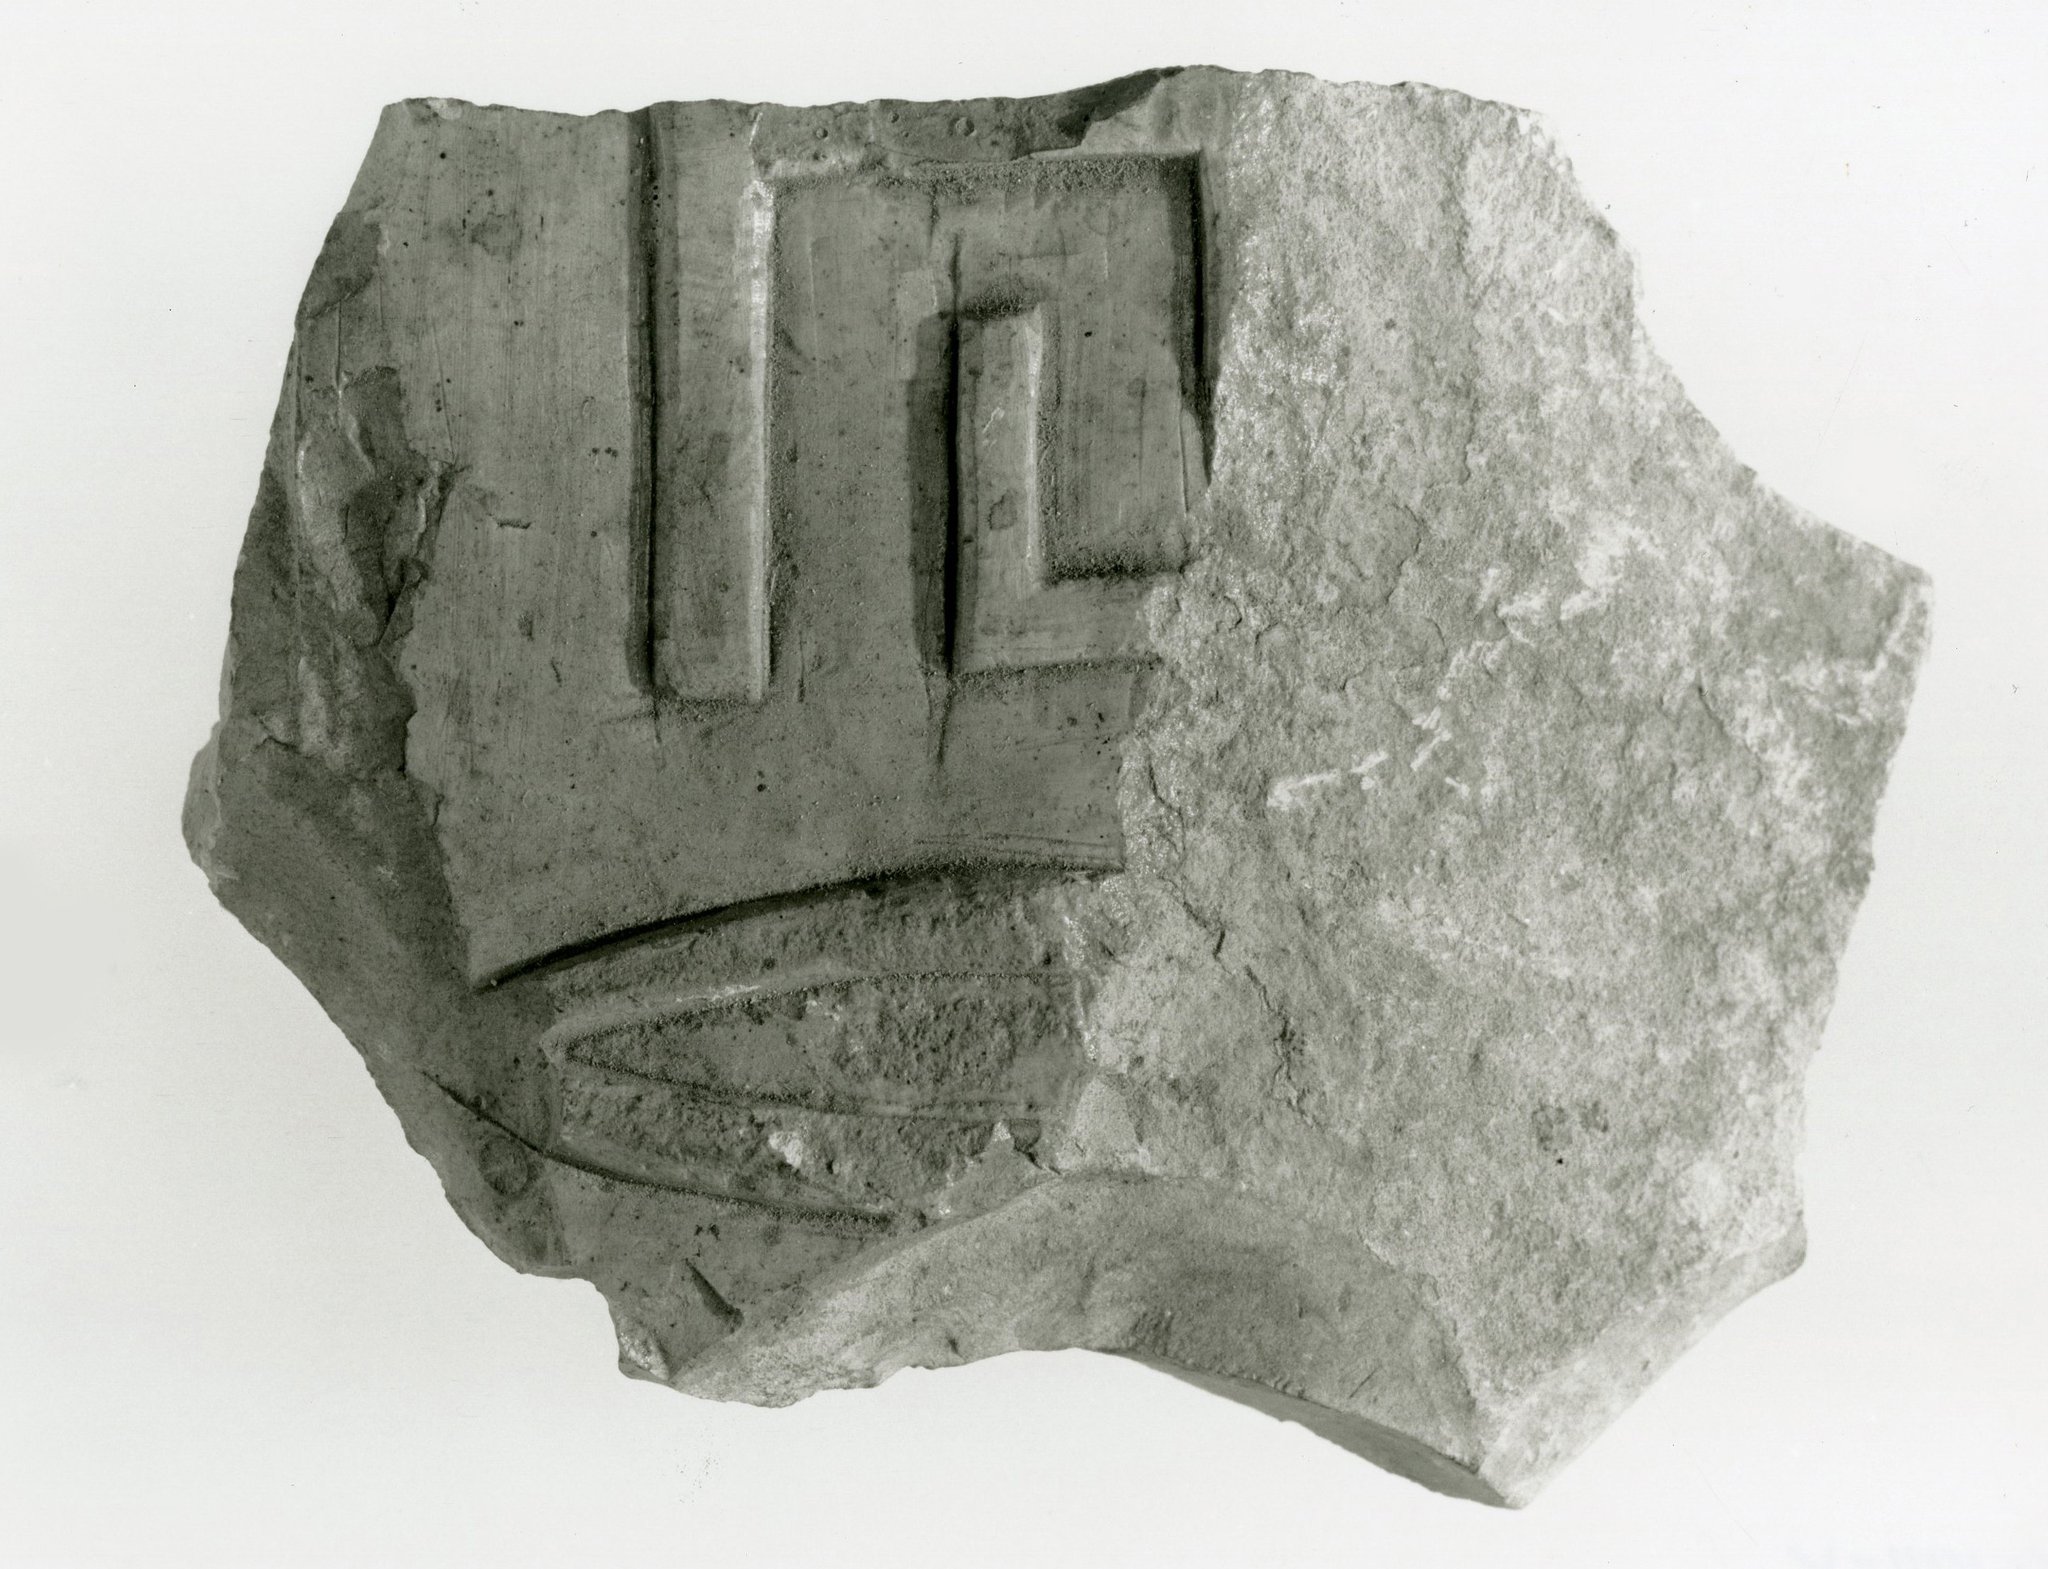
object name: relief, tomb of nespekashuty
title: Raised relief fragment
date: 664-610 BCE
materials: limestone, varnish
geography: egypt